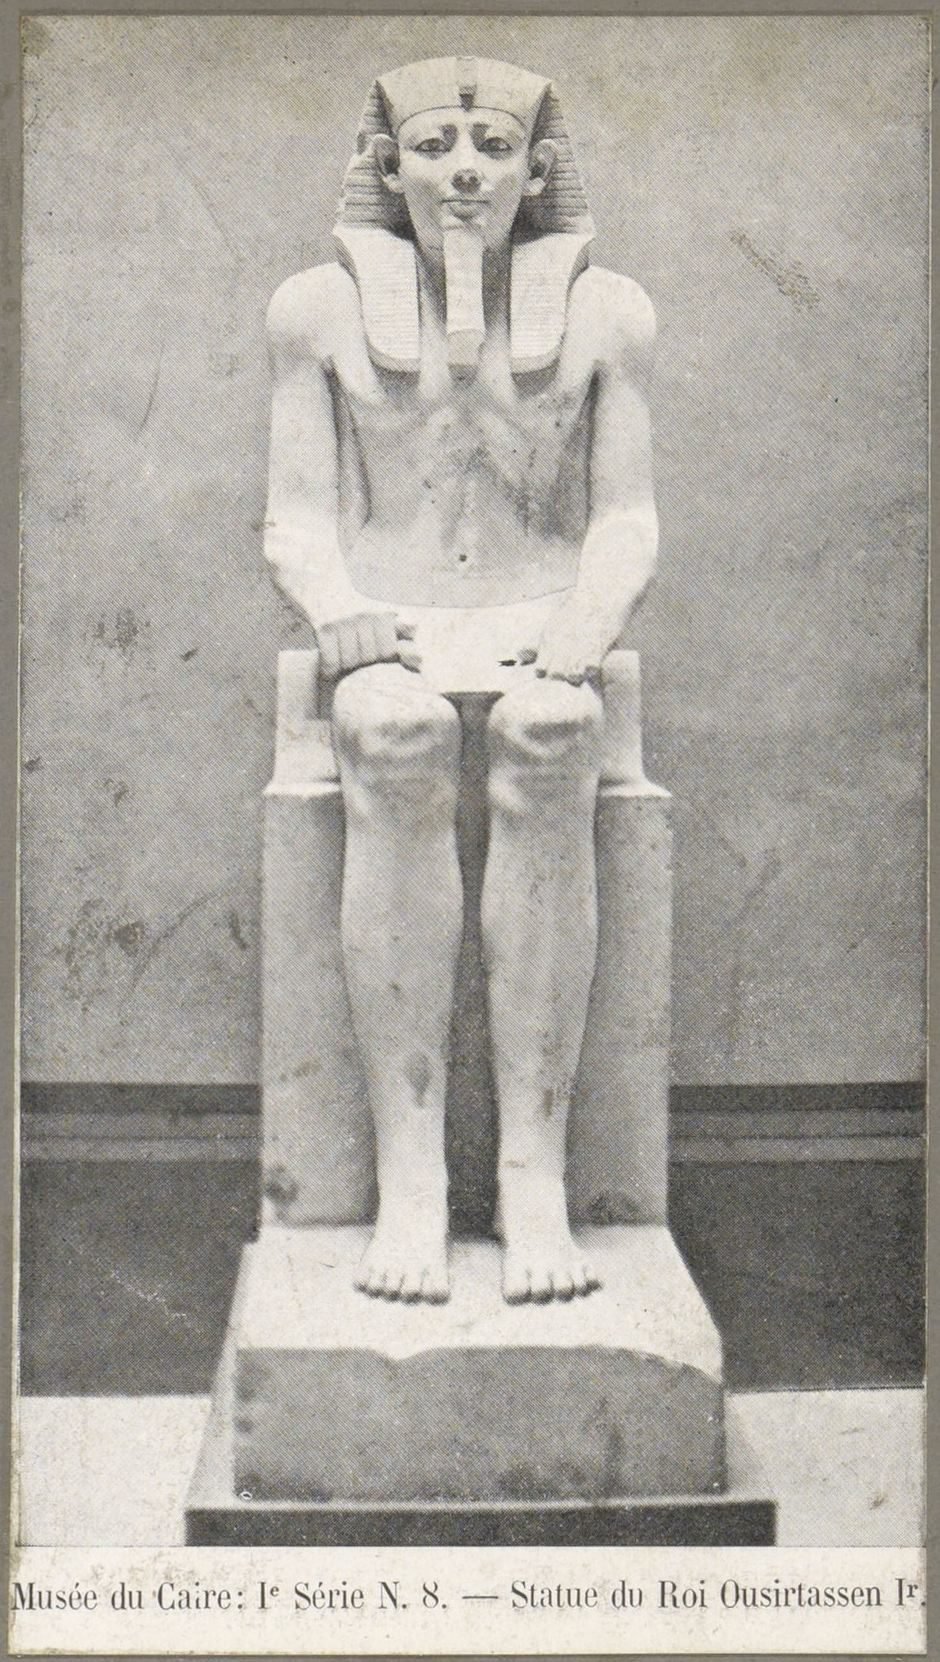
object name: album leaf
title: Musée du Caire Statue du Roi Ousirtassen Ir.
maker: gk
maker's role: fotograaf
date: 1895-1905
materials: paper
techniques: autotype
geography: cairo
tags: monument, statue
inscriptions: number: ‘Ie Série N. 8’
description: Onderdeel van Reisalbum met foto's van bezienswaardigheden in Griekenland en Egypte.